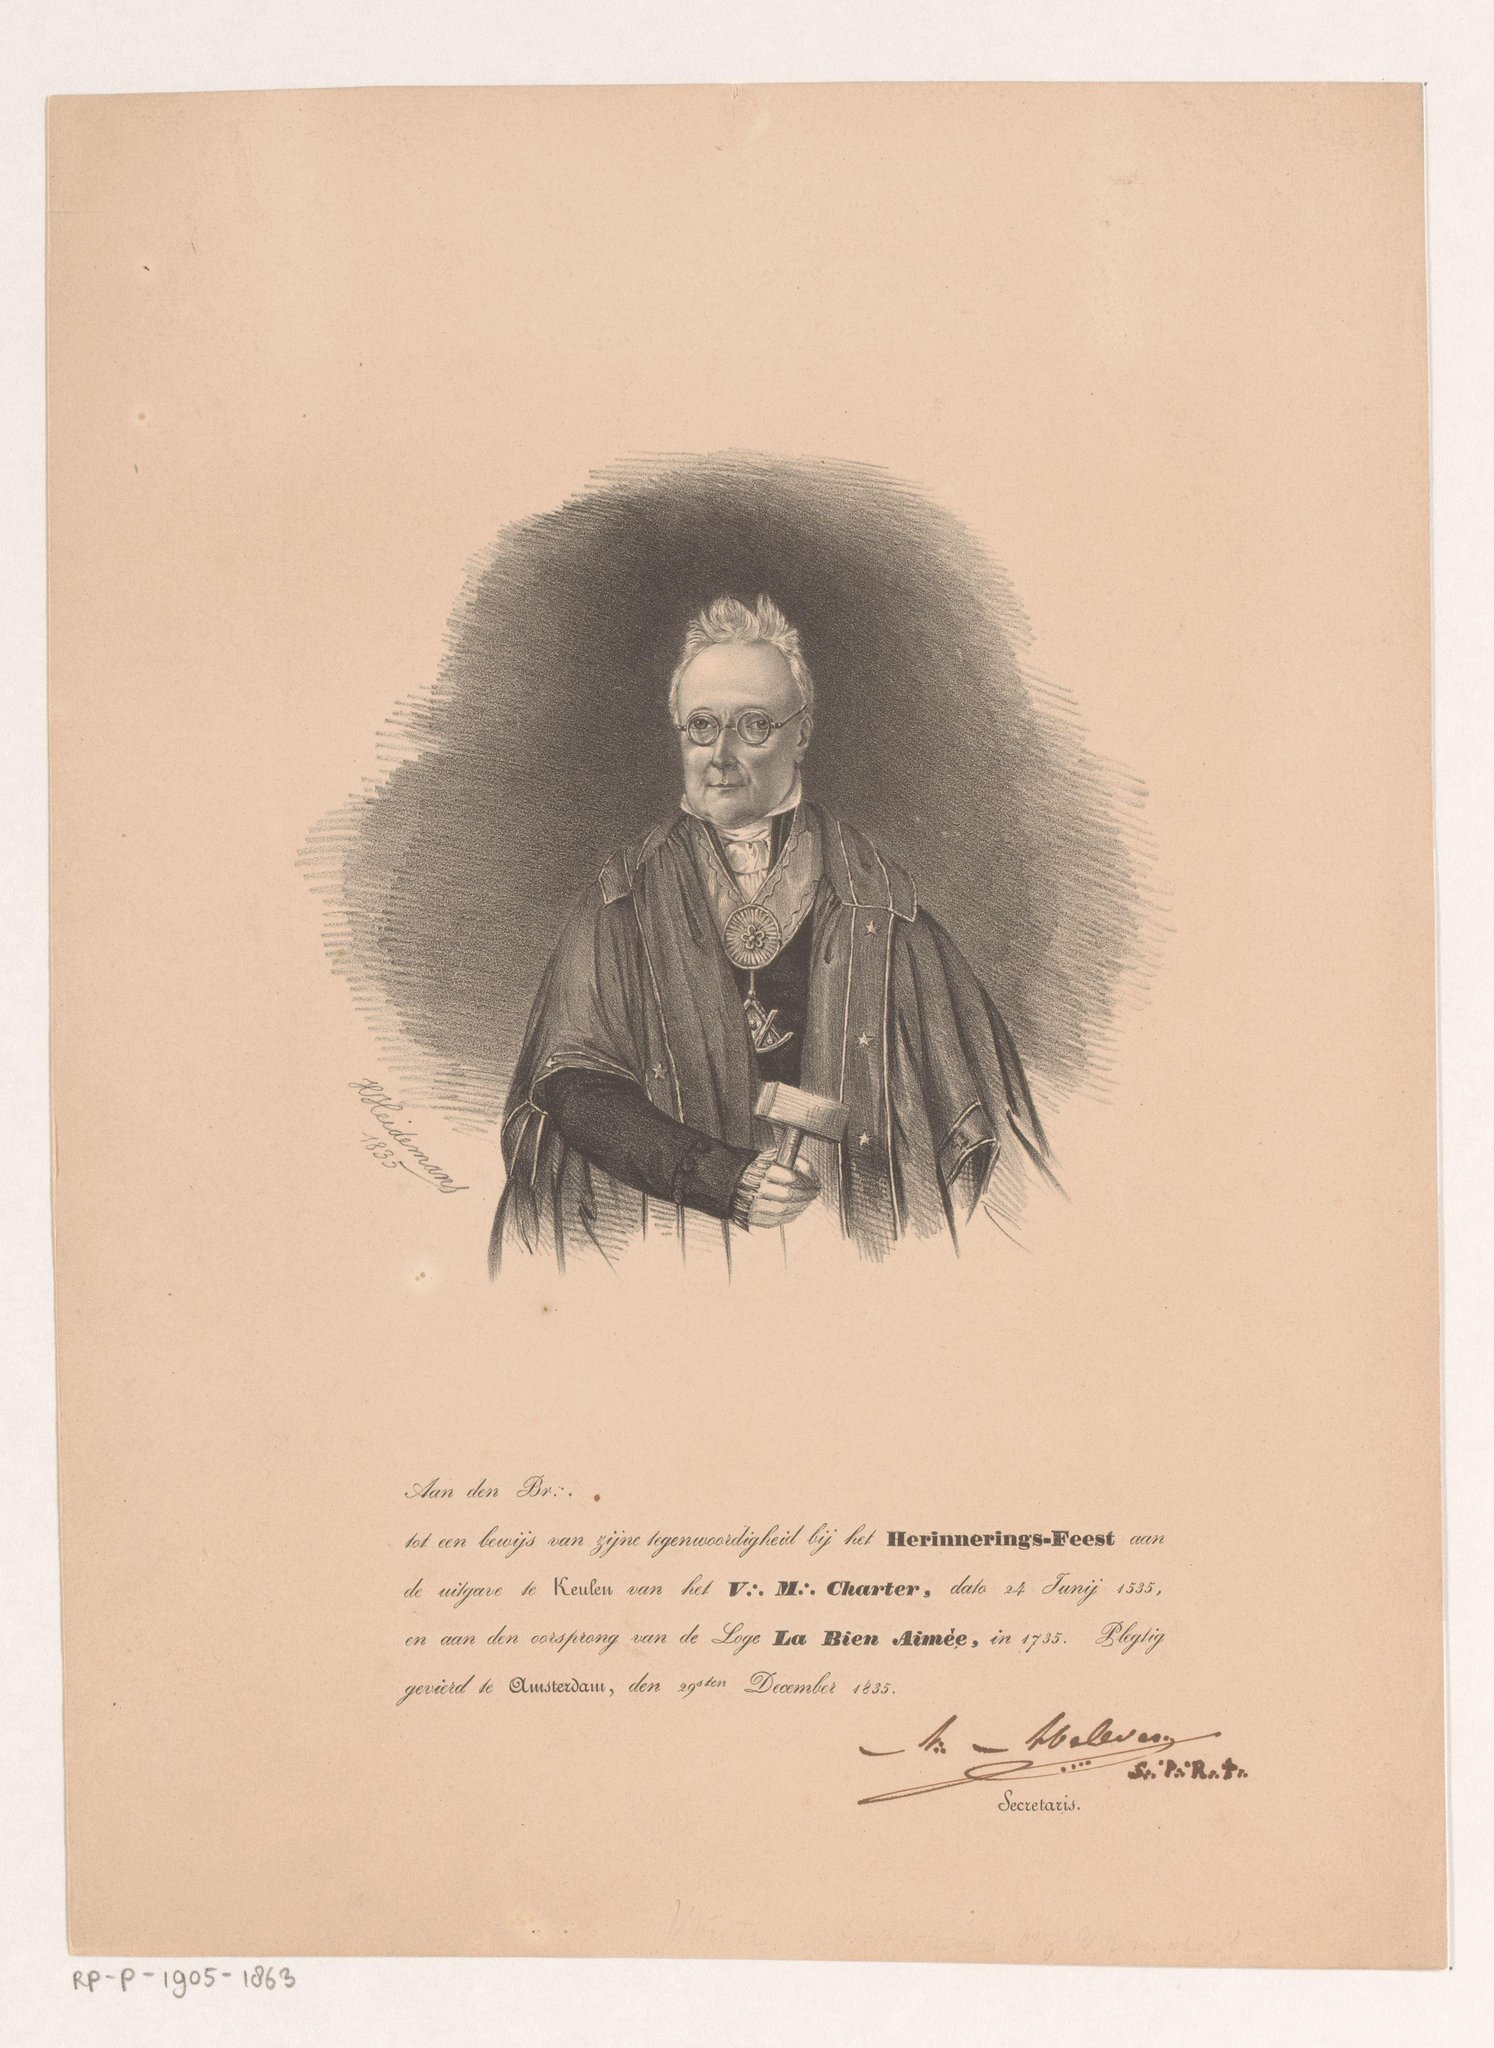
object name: print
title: Portret van Abeleven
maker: henri philippe heidemans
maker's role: print maker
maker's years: 1804-1864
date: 1835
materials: paper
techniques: letterpress printing, lithograph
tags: religious functionaries ~ freemasonry, tools, aids, implements ~ crafts and industries: hammer, historical persons (+ half-length portrait), conceptions and ideas visualized ~ freemasonry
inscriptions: collector's mark: Lugt 2228, signature:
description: De geportretteerde draagt een bril, mantel en een ketting met de tekenen van de orde van de vrijmetselarij. In zijn hand heeft hij een hamer. Onder het portret een tekst in boekdruk: een bewijs van aanwezigheid tijdens het herinneringsfeest ter ere van het verschijnen van het Charter van Keulen.